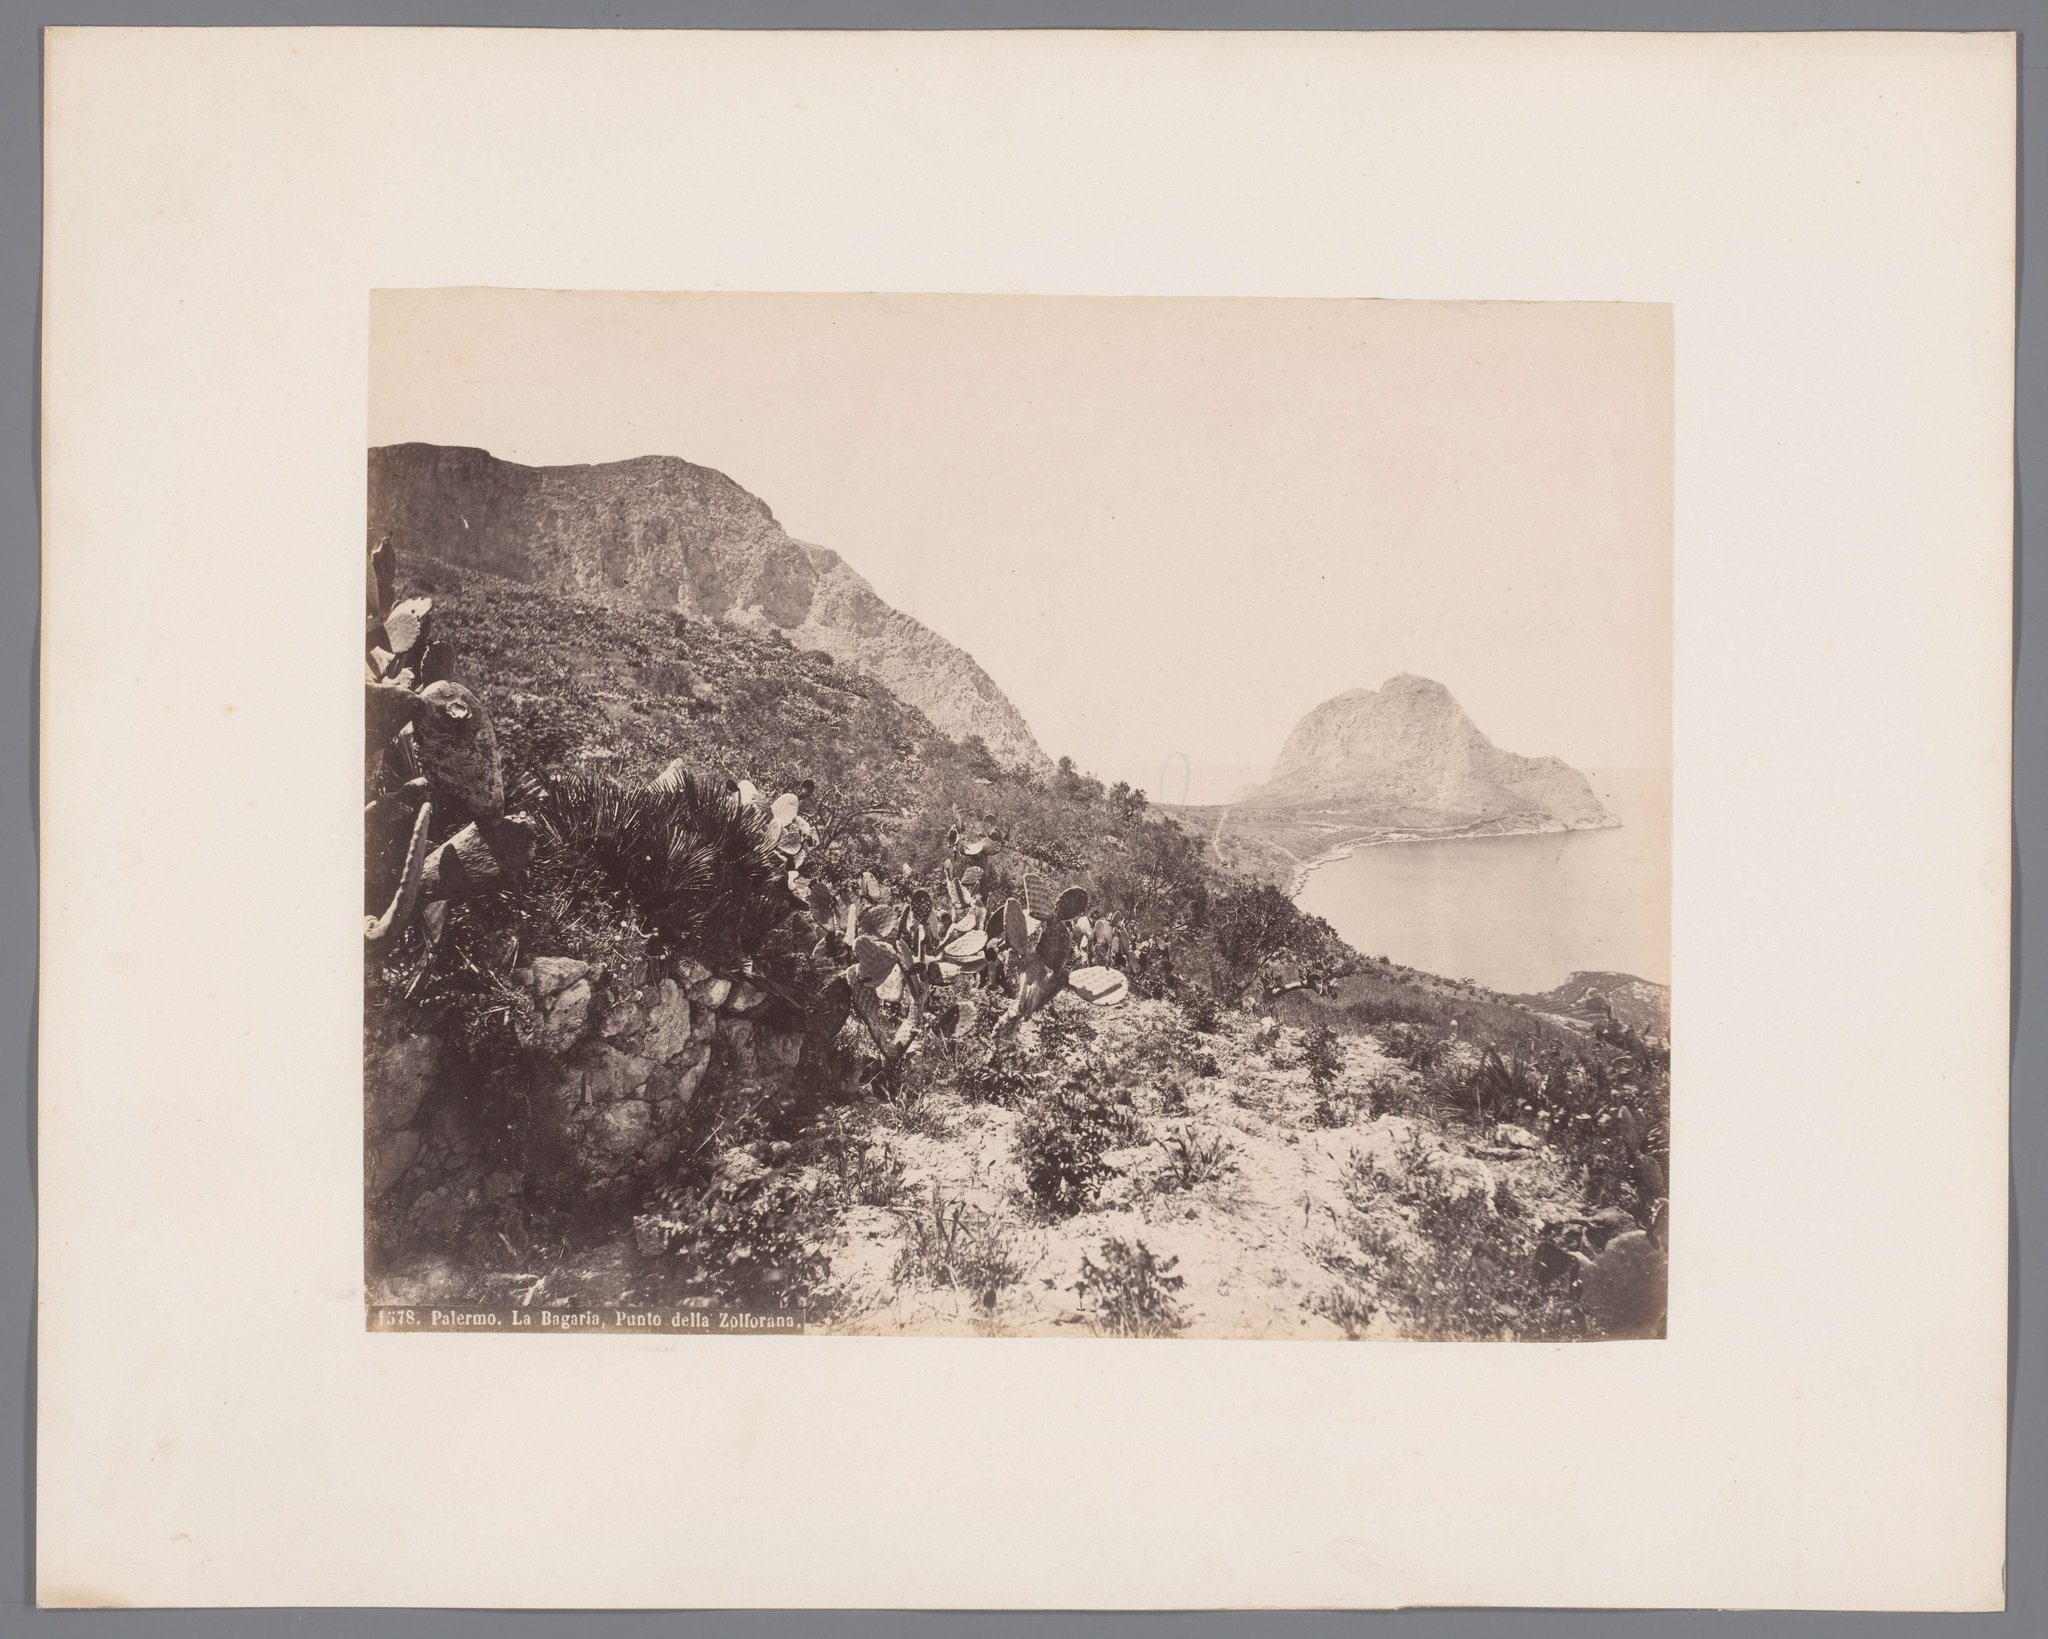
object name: photograph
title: La Bagaria, Punto della Zolforana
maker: roberto rive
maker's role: fotograaf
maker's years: 1825-1868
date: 1860-1889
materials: cardboard, paper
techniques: albumen print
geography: palermo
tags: gulf, bay, plants and herbs: cactus, coast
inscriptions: inscription: ‘Rive (t)’, number: ‘1578.’